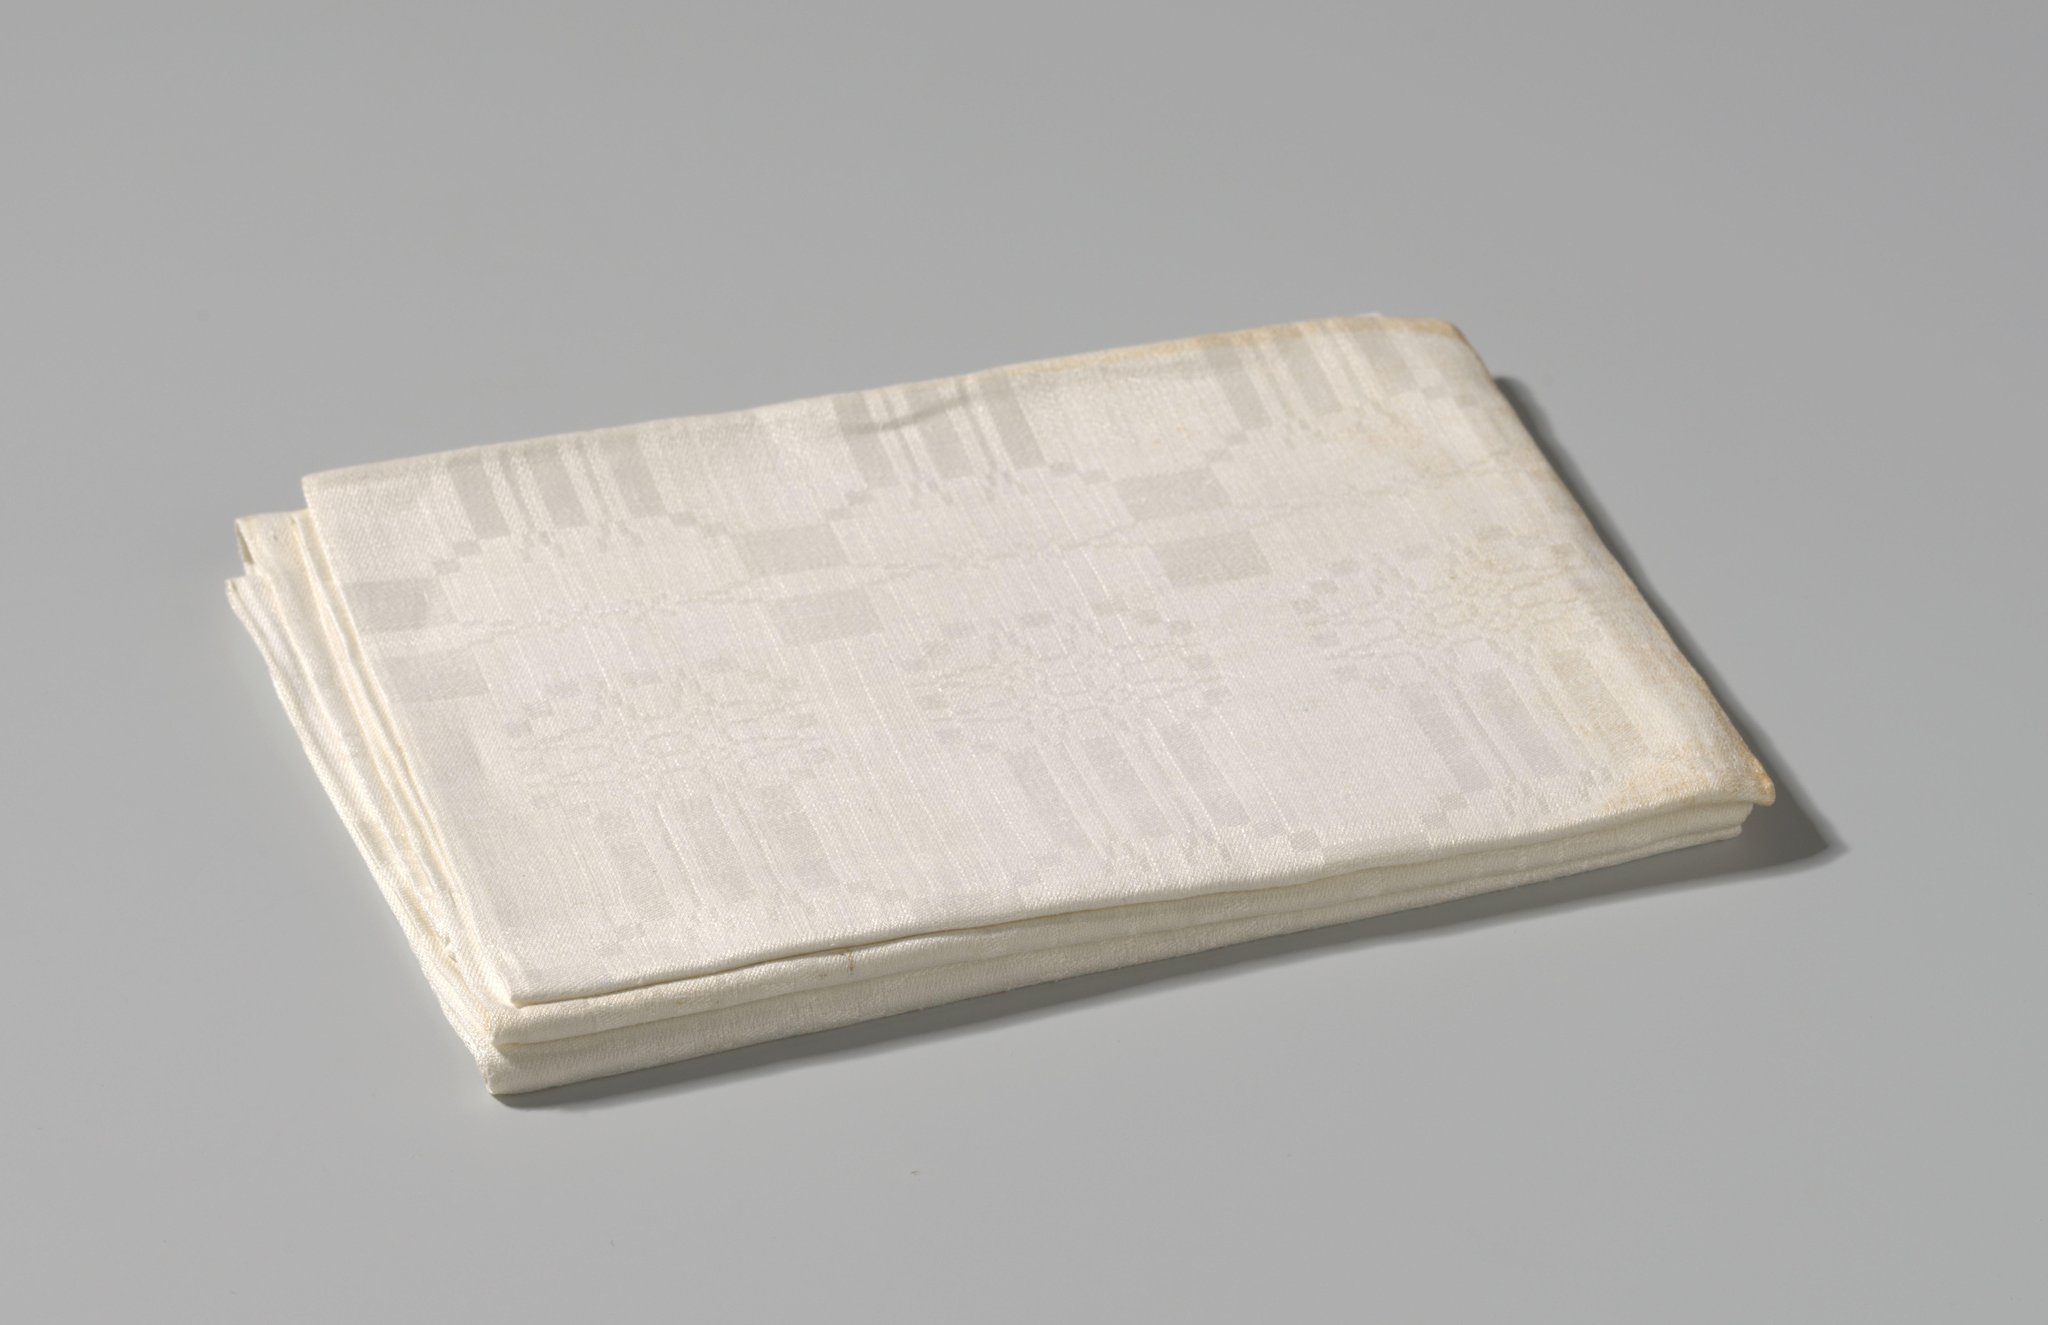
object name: napkin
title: Servet van linnen met pellenpatroon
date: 1700-1780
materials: linen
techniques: peeled fabric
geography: northern netherlands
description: wit linnen servet met pellen patroon, z.g. Oranjeboom, merk WS 24